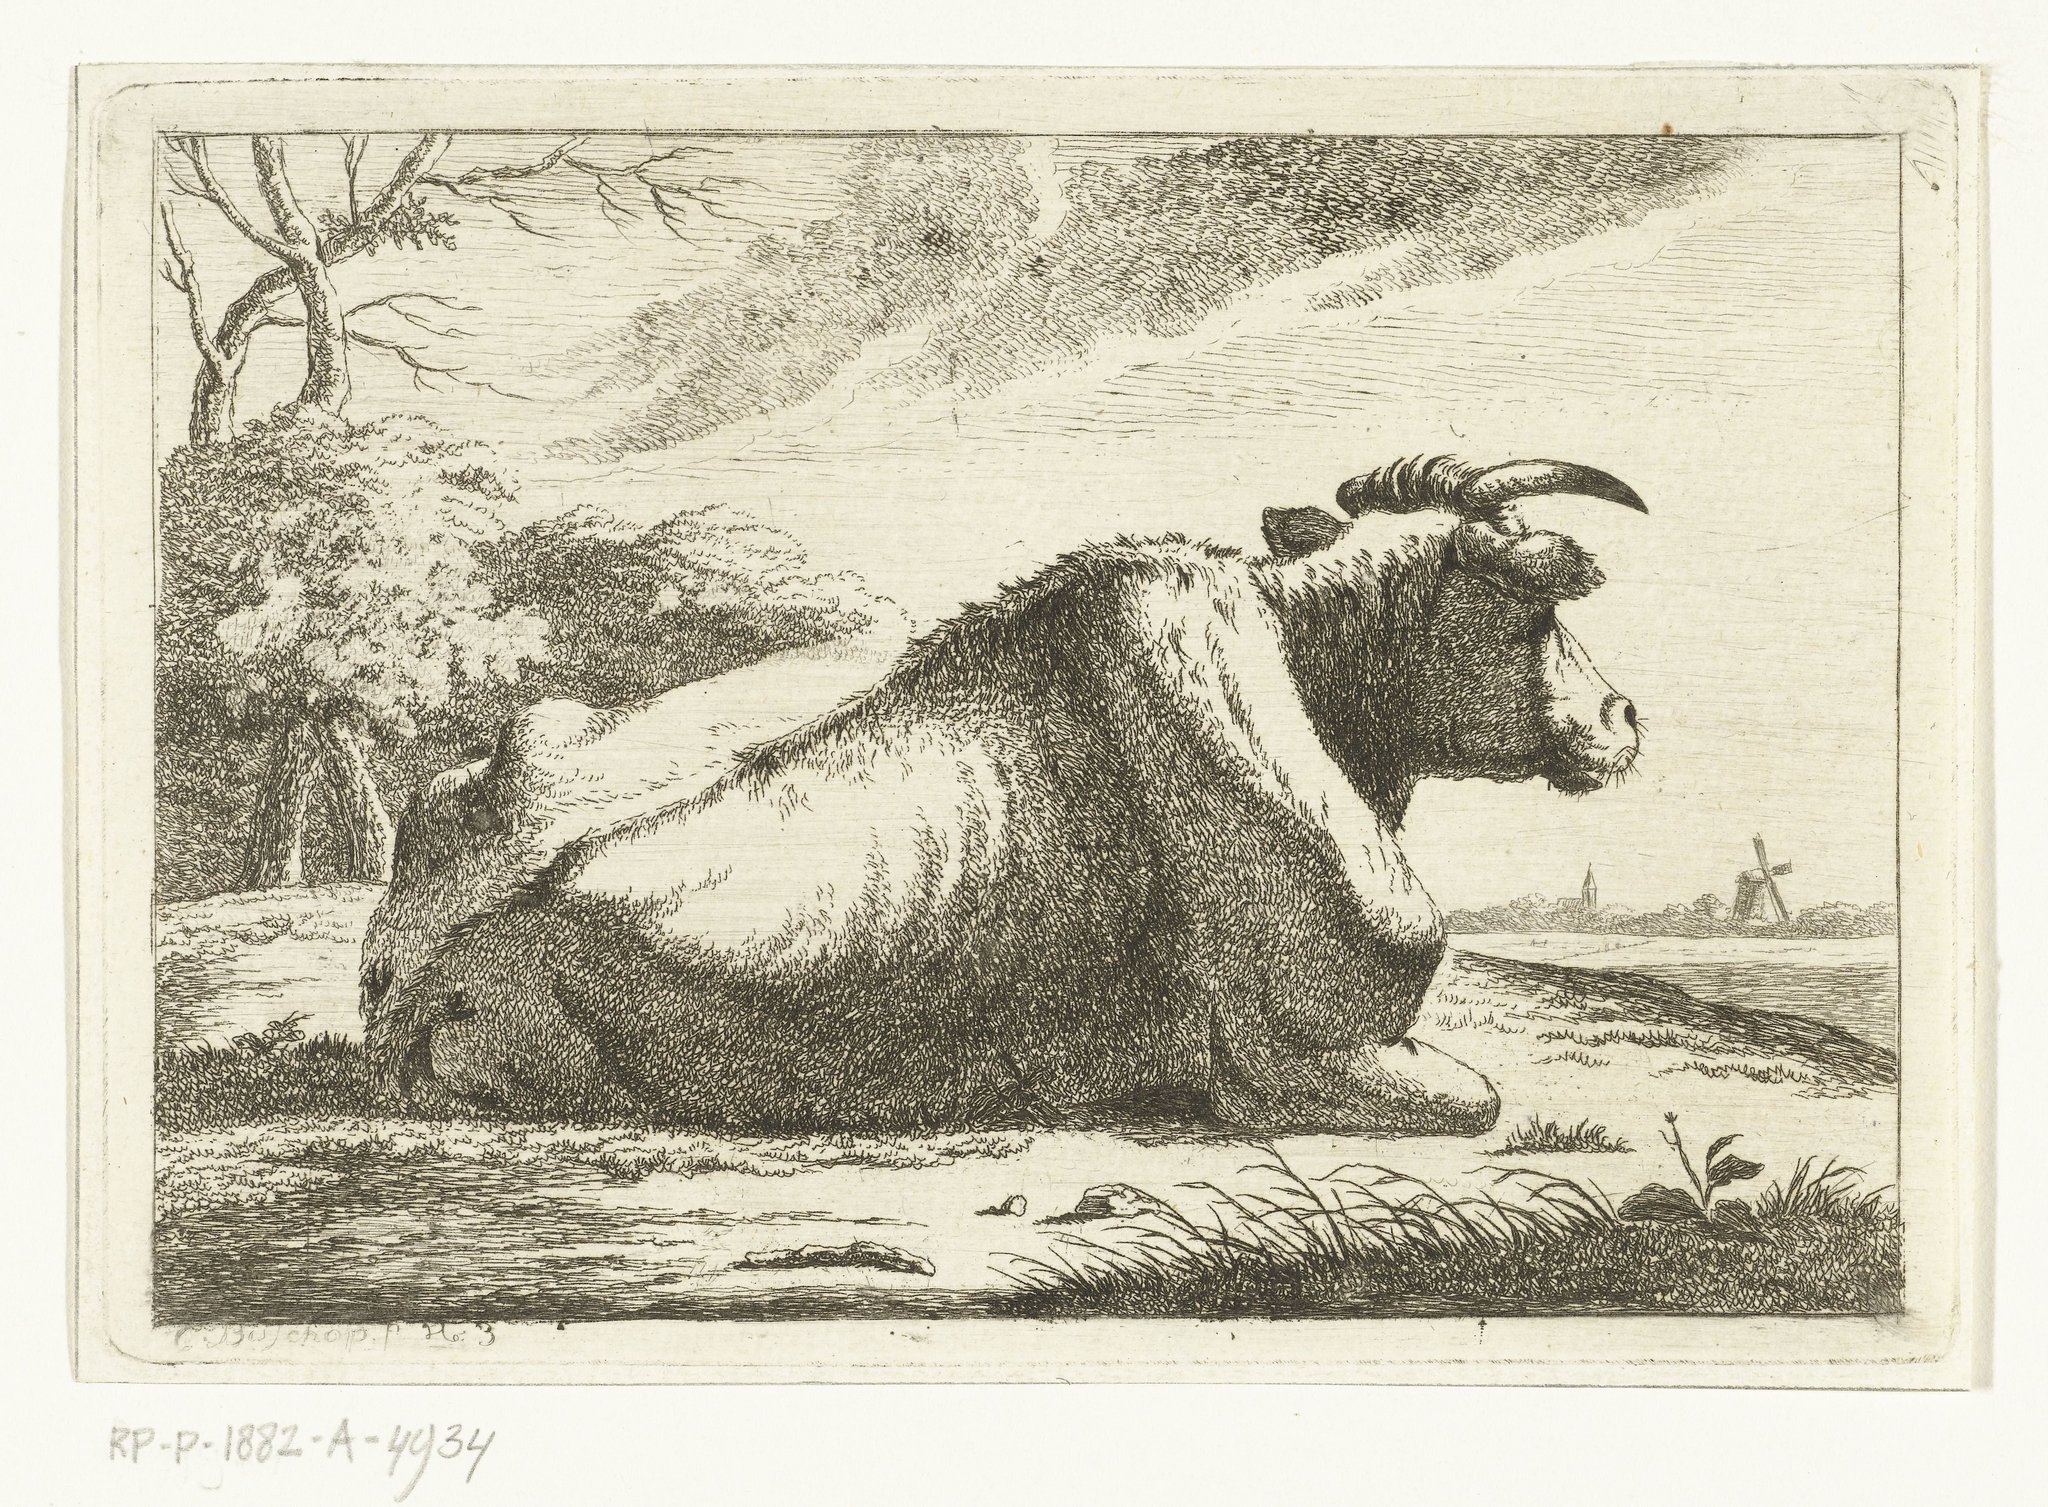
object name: print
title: Landschap met liggende koe op rug gezien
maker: cornelis bisschop (1762-1829)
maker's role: print maker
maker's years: 1762-1829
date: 1777-1829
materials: paper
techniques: etching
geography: netherlands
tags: cow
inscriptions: collector's mark: Lugt 2228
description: Prent uit serie van vier prenten met koeien.